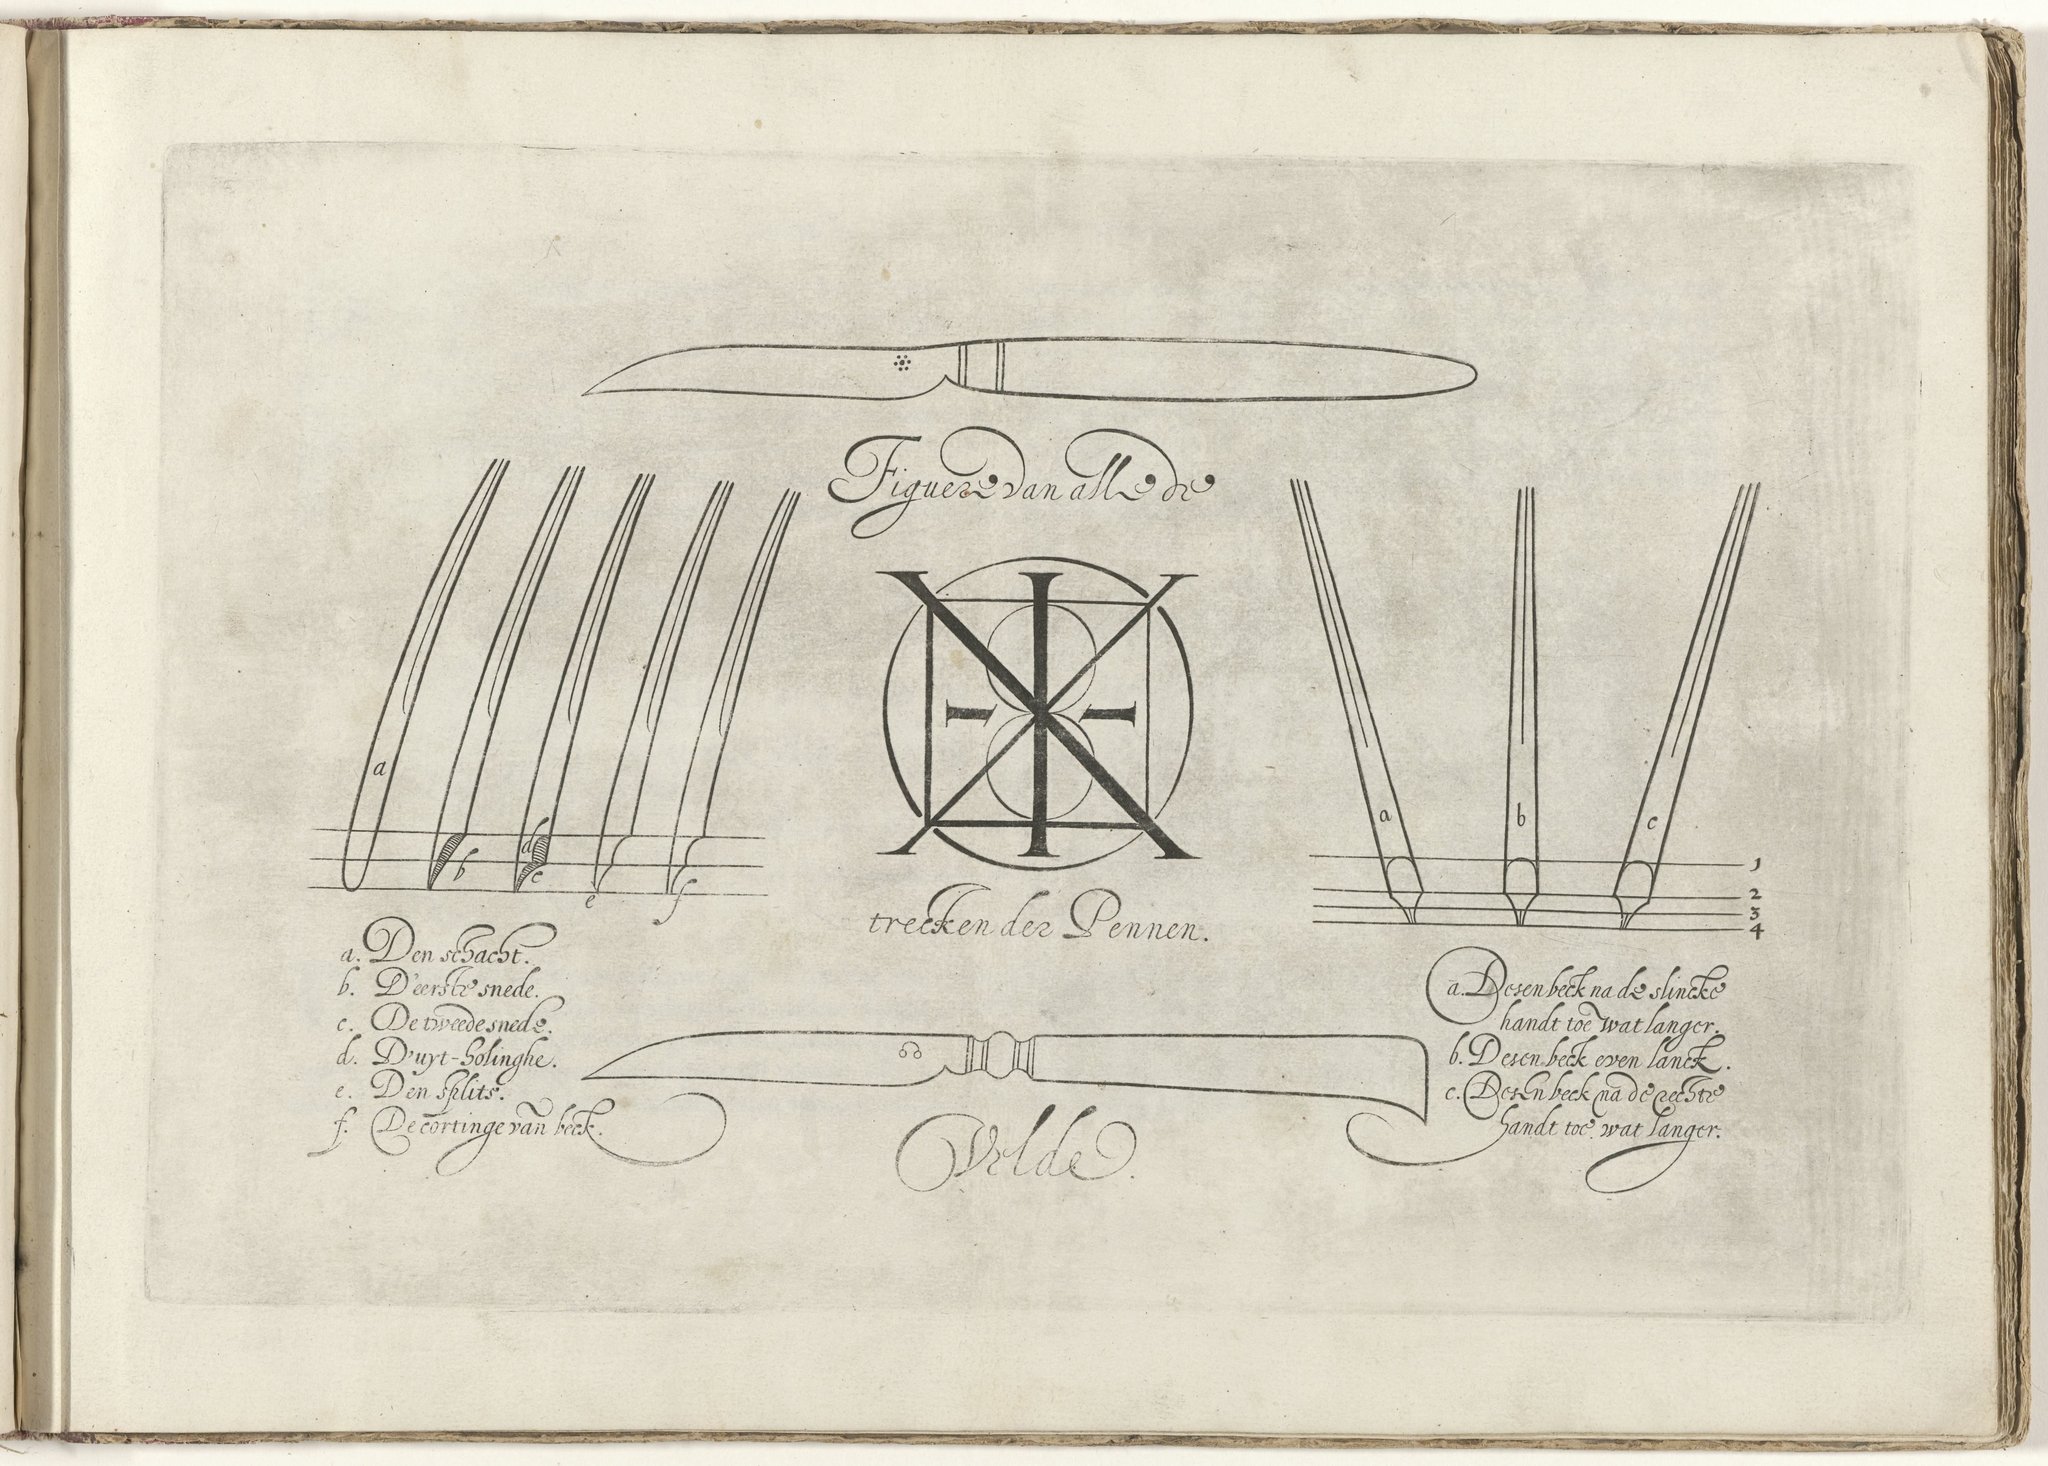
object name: album leaf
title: Spieghel der schrijfkonste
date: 1605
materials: paper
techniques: engraving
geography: amsterdam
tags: writing tools, calligraphy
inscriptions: collector's mark: Lugt 2228, collector's mark: Lugt 2760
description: Het snijden van een ganzenveer. In acht stappen wordt verteld hoe de punt gesneden moet worden. Daaronder twee legenda's. Boven en onder een mes. Een geometrisch figuur in het midden. De prent maakt deel uit van een album.